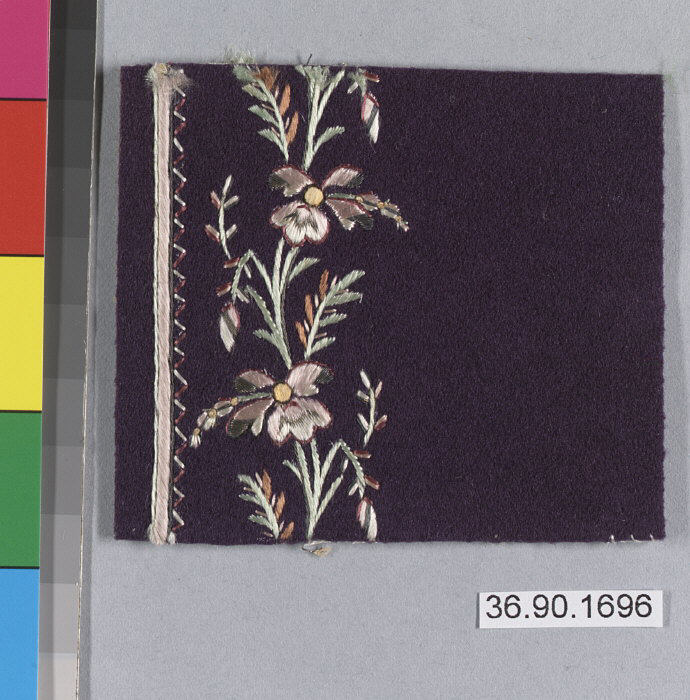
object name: sample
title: Embroidery sample for a man’s suit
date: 1785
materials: metal thread, silk, wool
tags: flowers